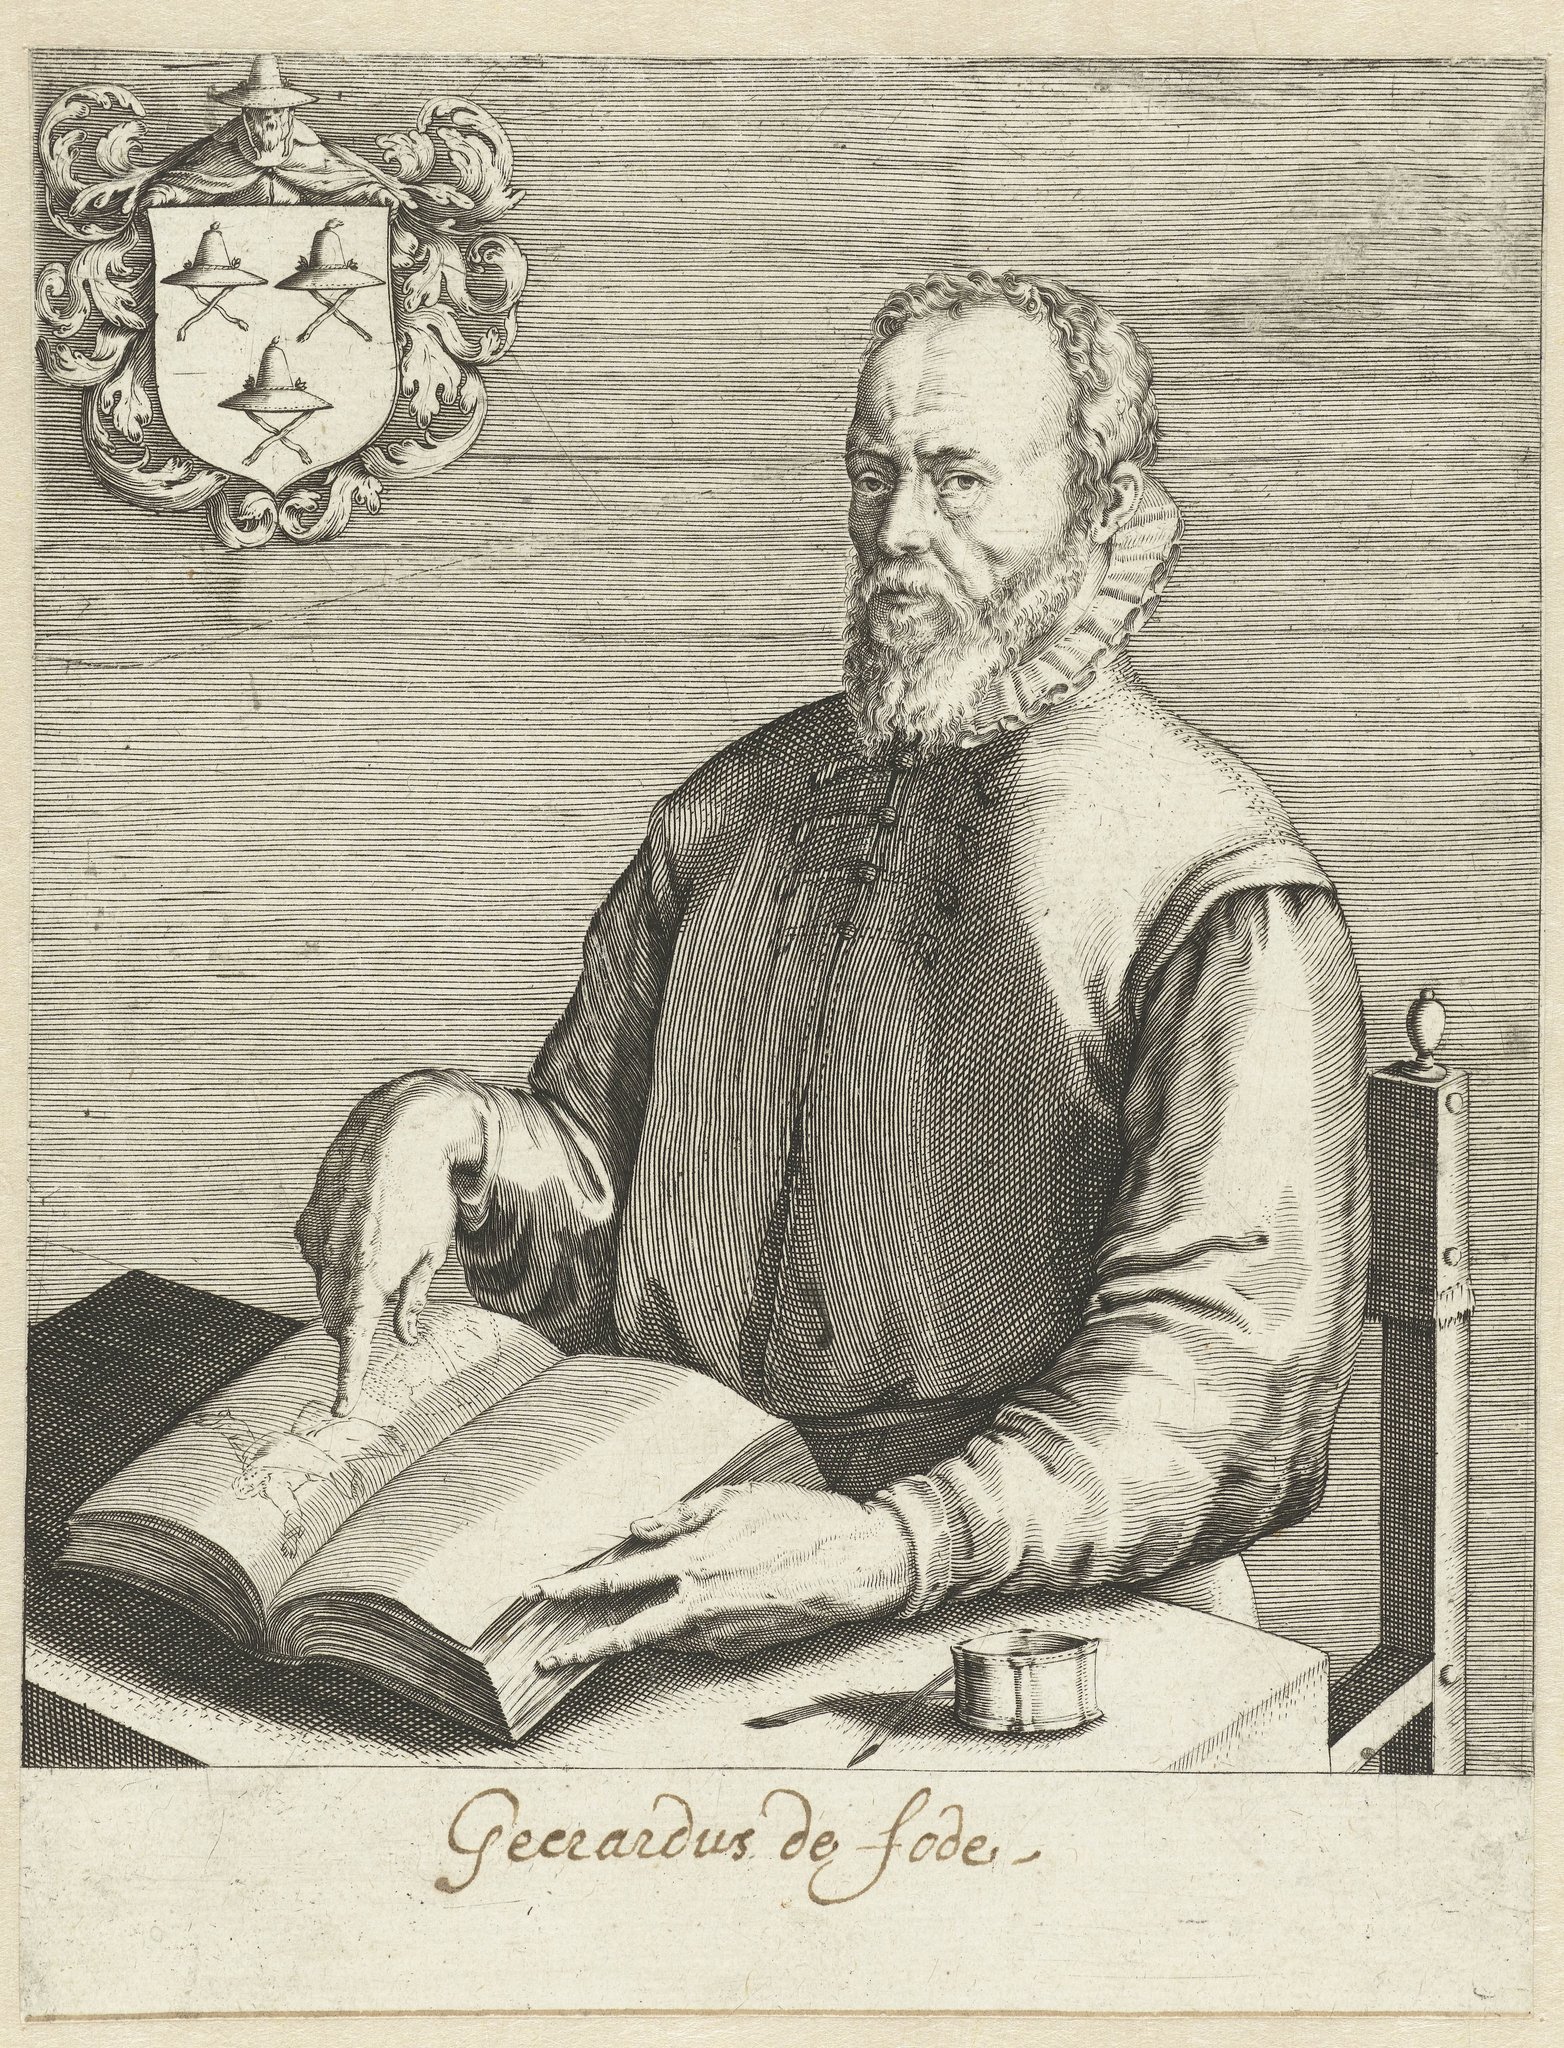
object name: print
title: Portret van Gerard de Jode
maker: Anonymous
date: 1624-1679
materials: paper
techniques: engraving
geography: low countries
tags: gerard de jode, historical persons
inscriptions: collector's mark: Lugt 240, inscription: ‘Geerardus de Jode’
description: Portret van een man, ten halven lijve, zitten aan een tafel, wijzend in een boek. Linksboven een wapen. Onder de voorstelling is ruimte gelaten voor een onderschrift.